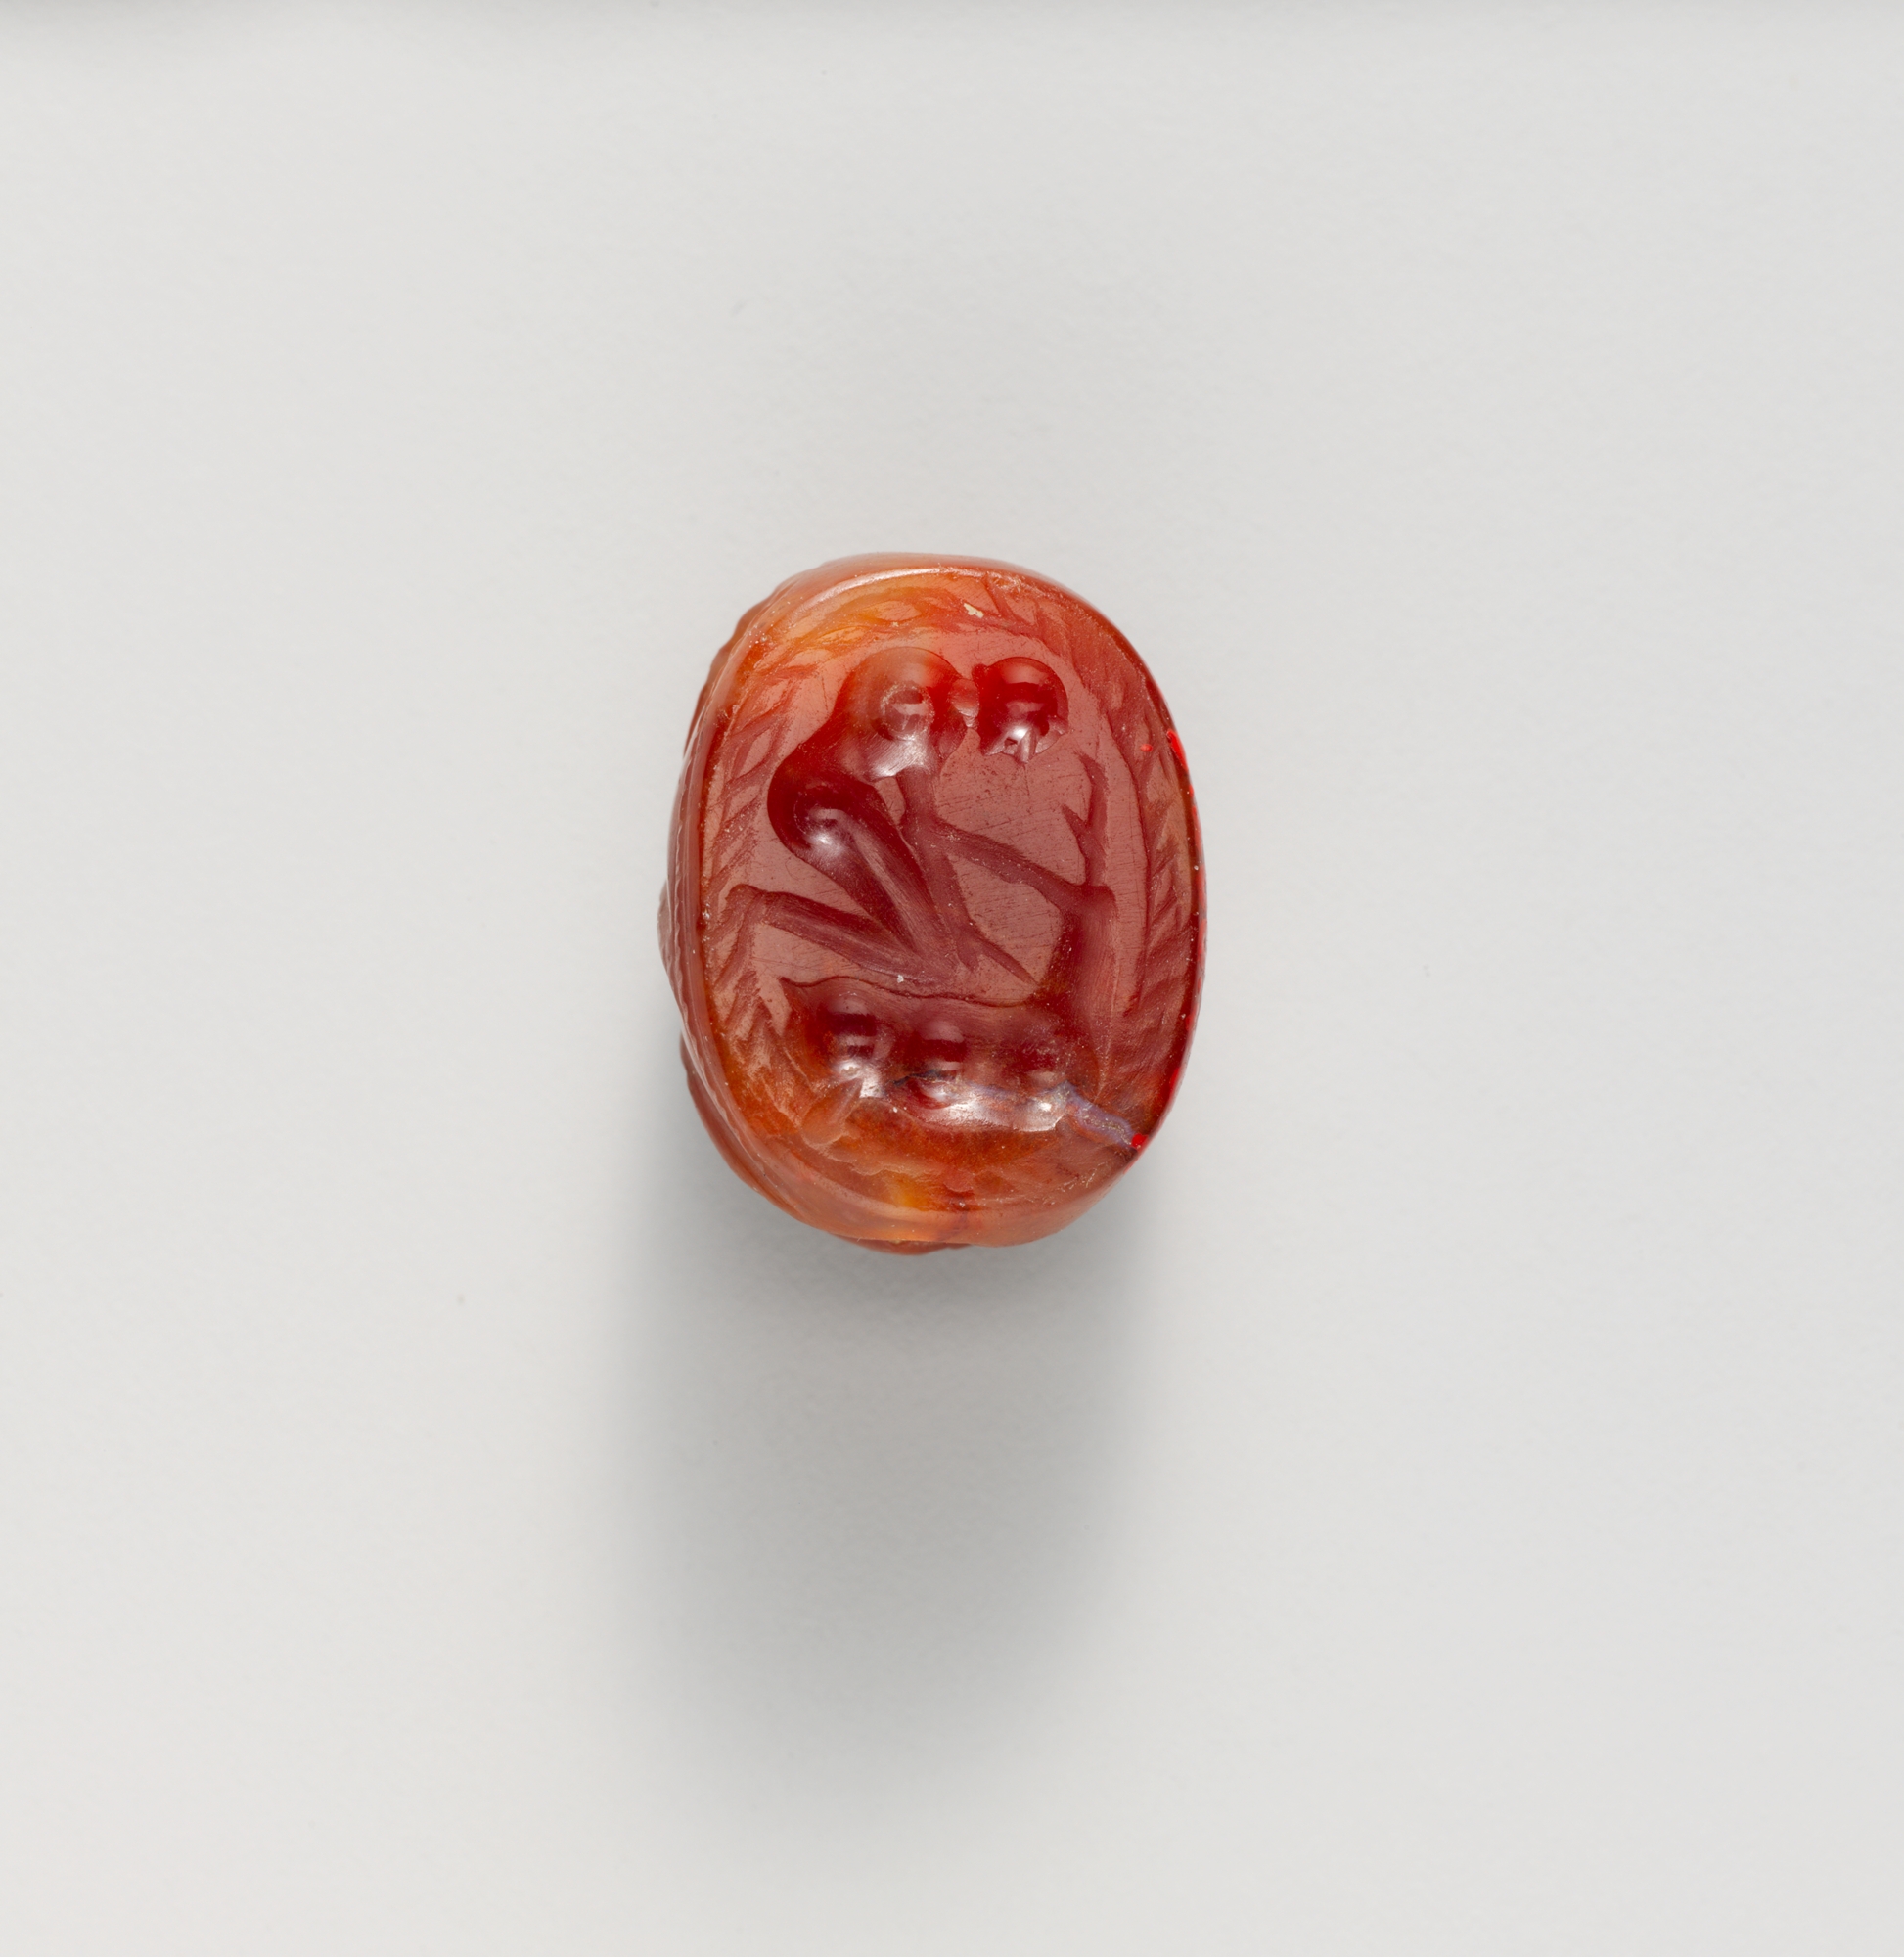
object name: scarab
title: Carnelian scarab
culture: etruscan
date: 325-200 BCE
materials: gemstone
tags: deer